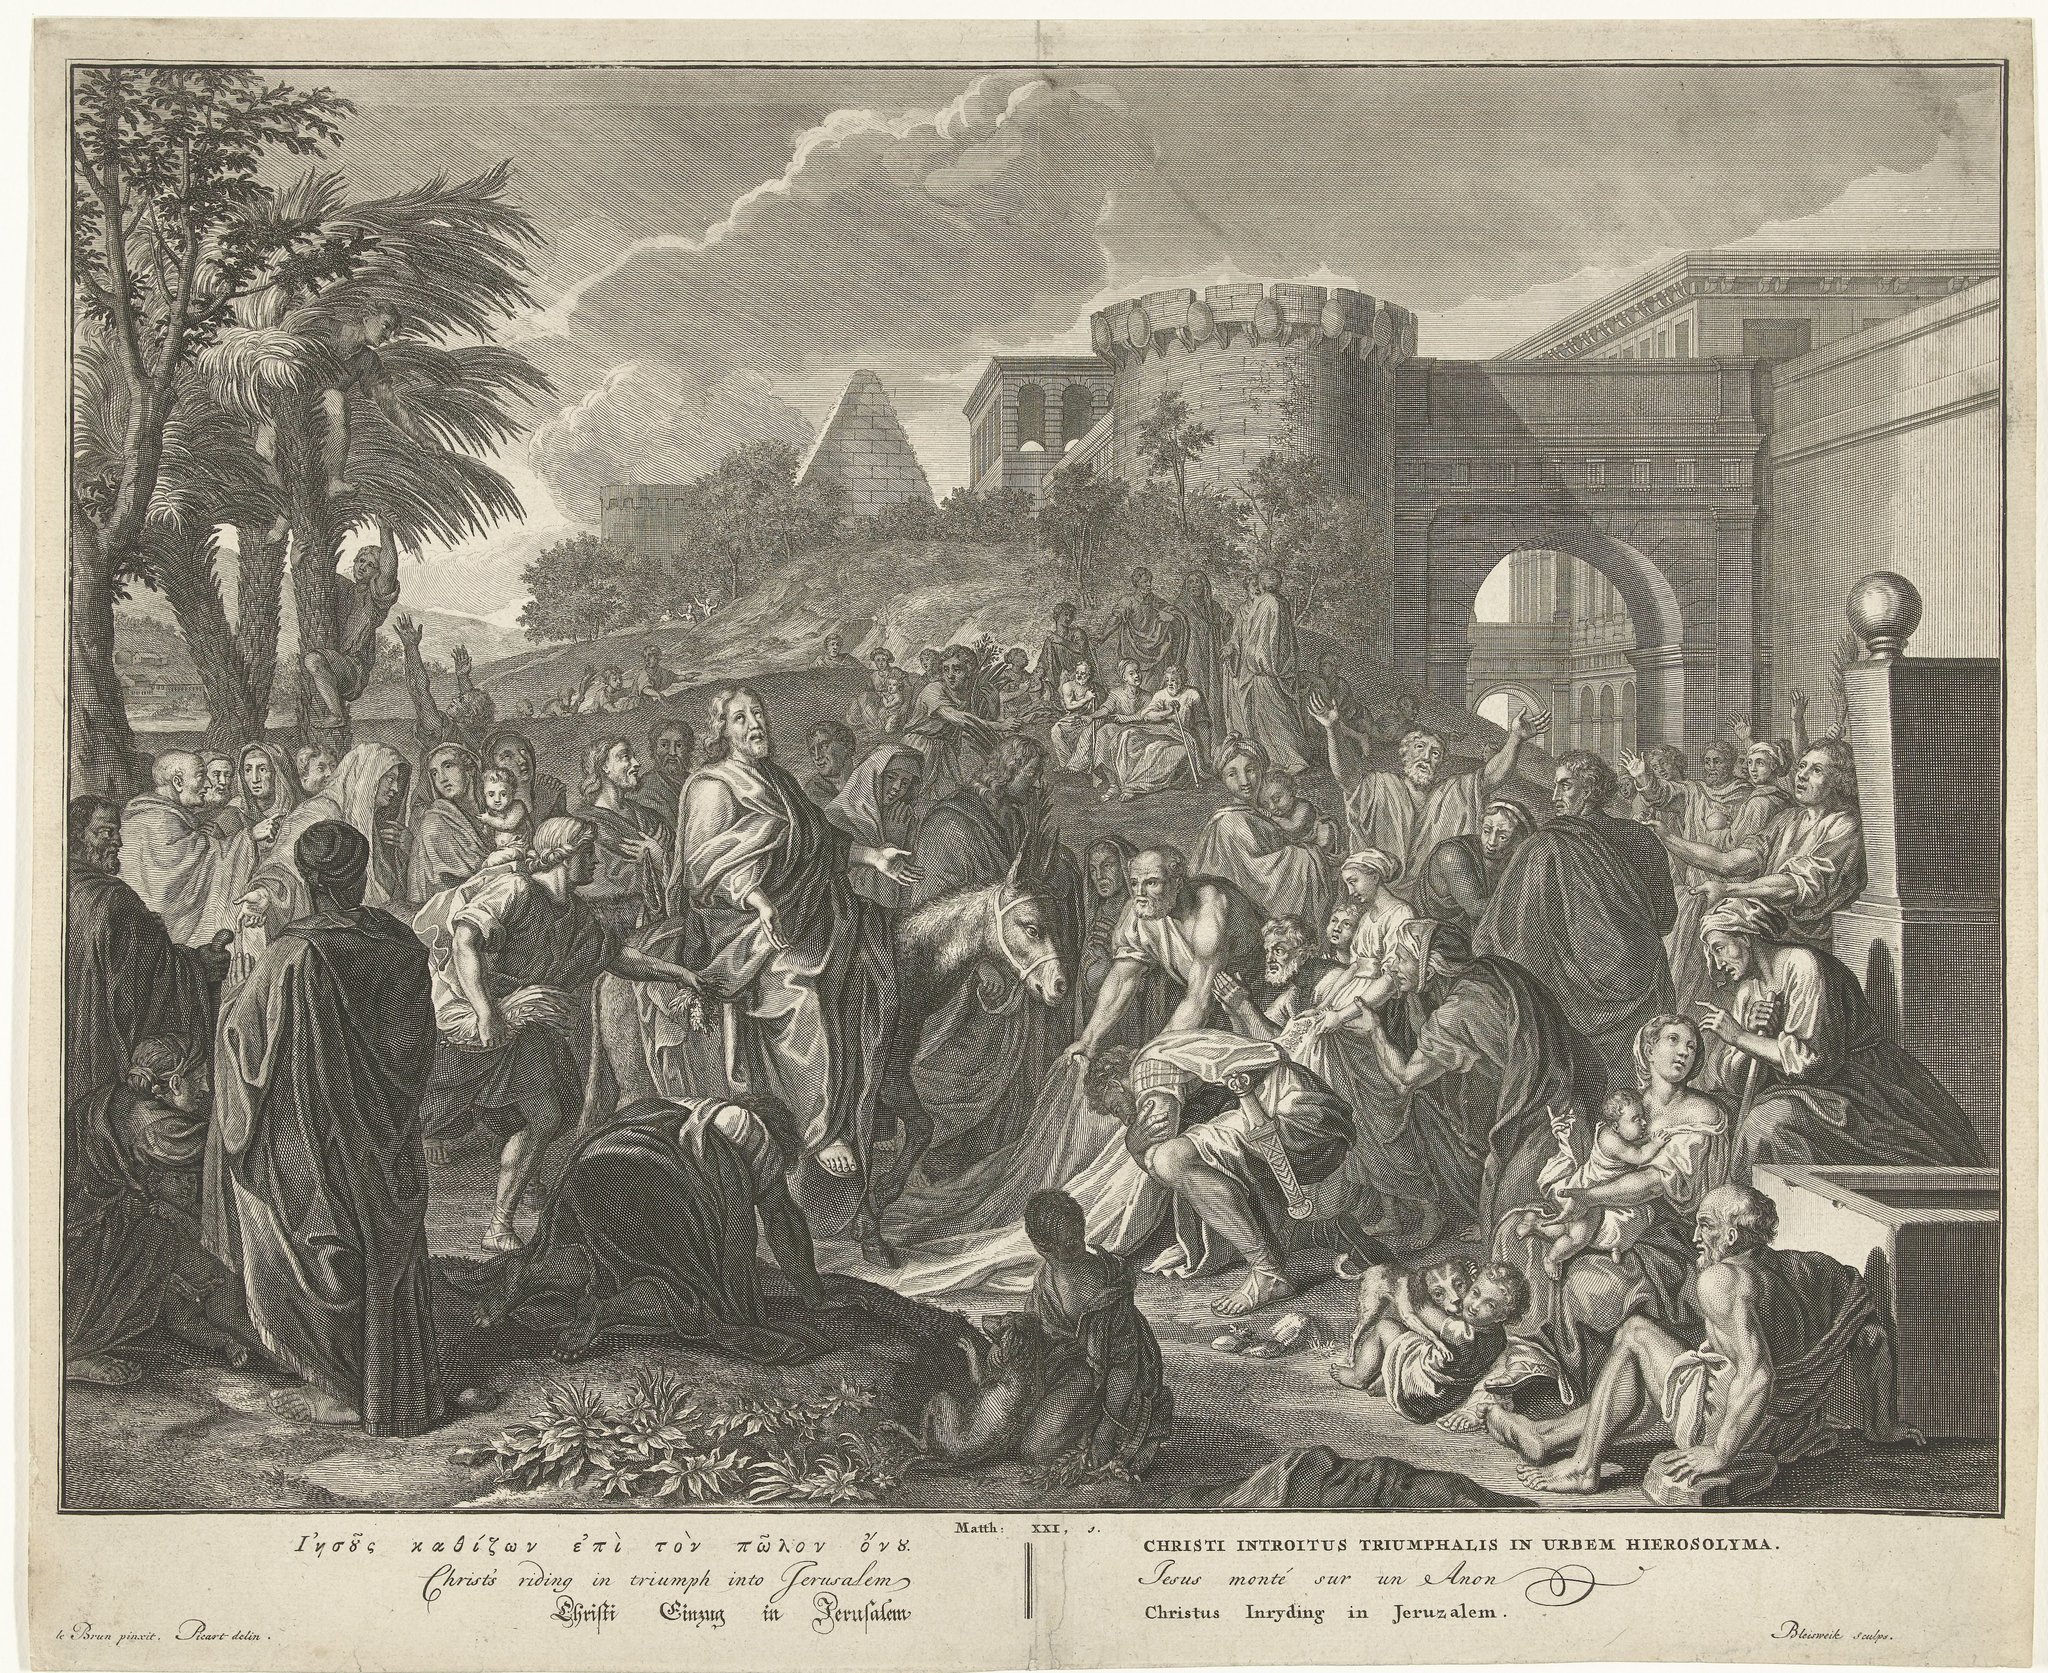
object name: print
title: Christus inryding in Jeruzalem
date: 1681-1728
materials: paper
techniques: engraving, etching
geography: leiden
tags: entry into jerusalem: people spreading their clothes before christ on the ass, and waving palm branches (matthew 21:1-11, 21:14-16; mark 11:1-11; luke 19:28-40; john 12:12-19)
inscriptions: collector's mark: Lugt 2228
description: Prent voor: Hoet, Gerard, Taferelen der voornaamste geschiedenissen van het Oude en Nieuwe Testament, en andere boeken, bij de Heilige Schrift gevoegt, door Hoet, Houbraken, en Picart getekent en van de beste meesters in koper gesneden en met beschrijvingen uitgebreid, 3 delen, 's-Gravenhage, Pieter de Hondt, 1728